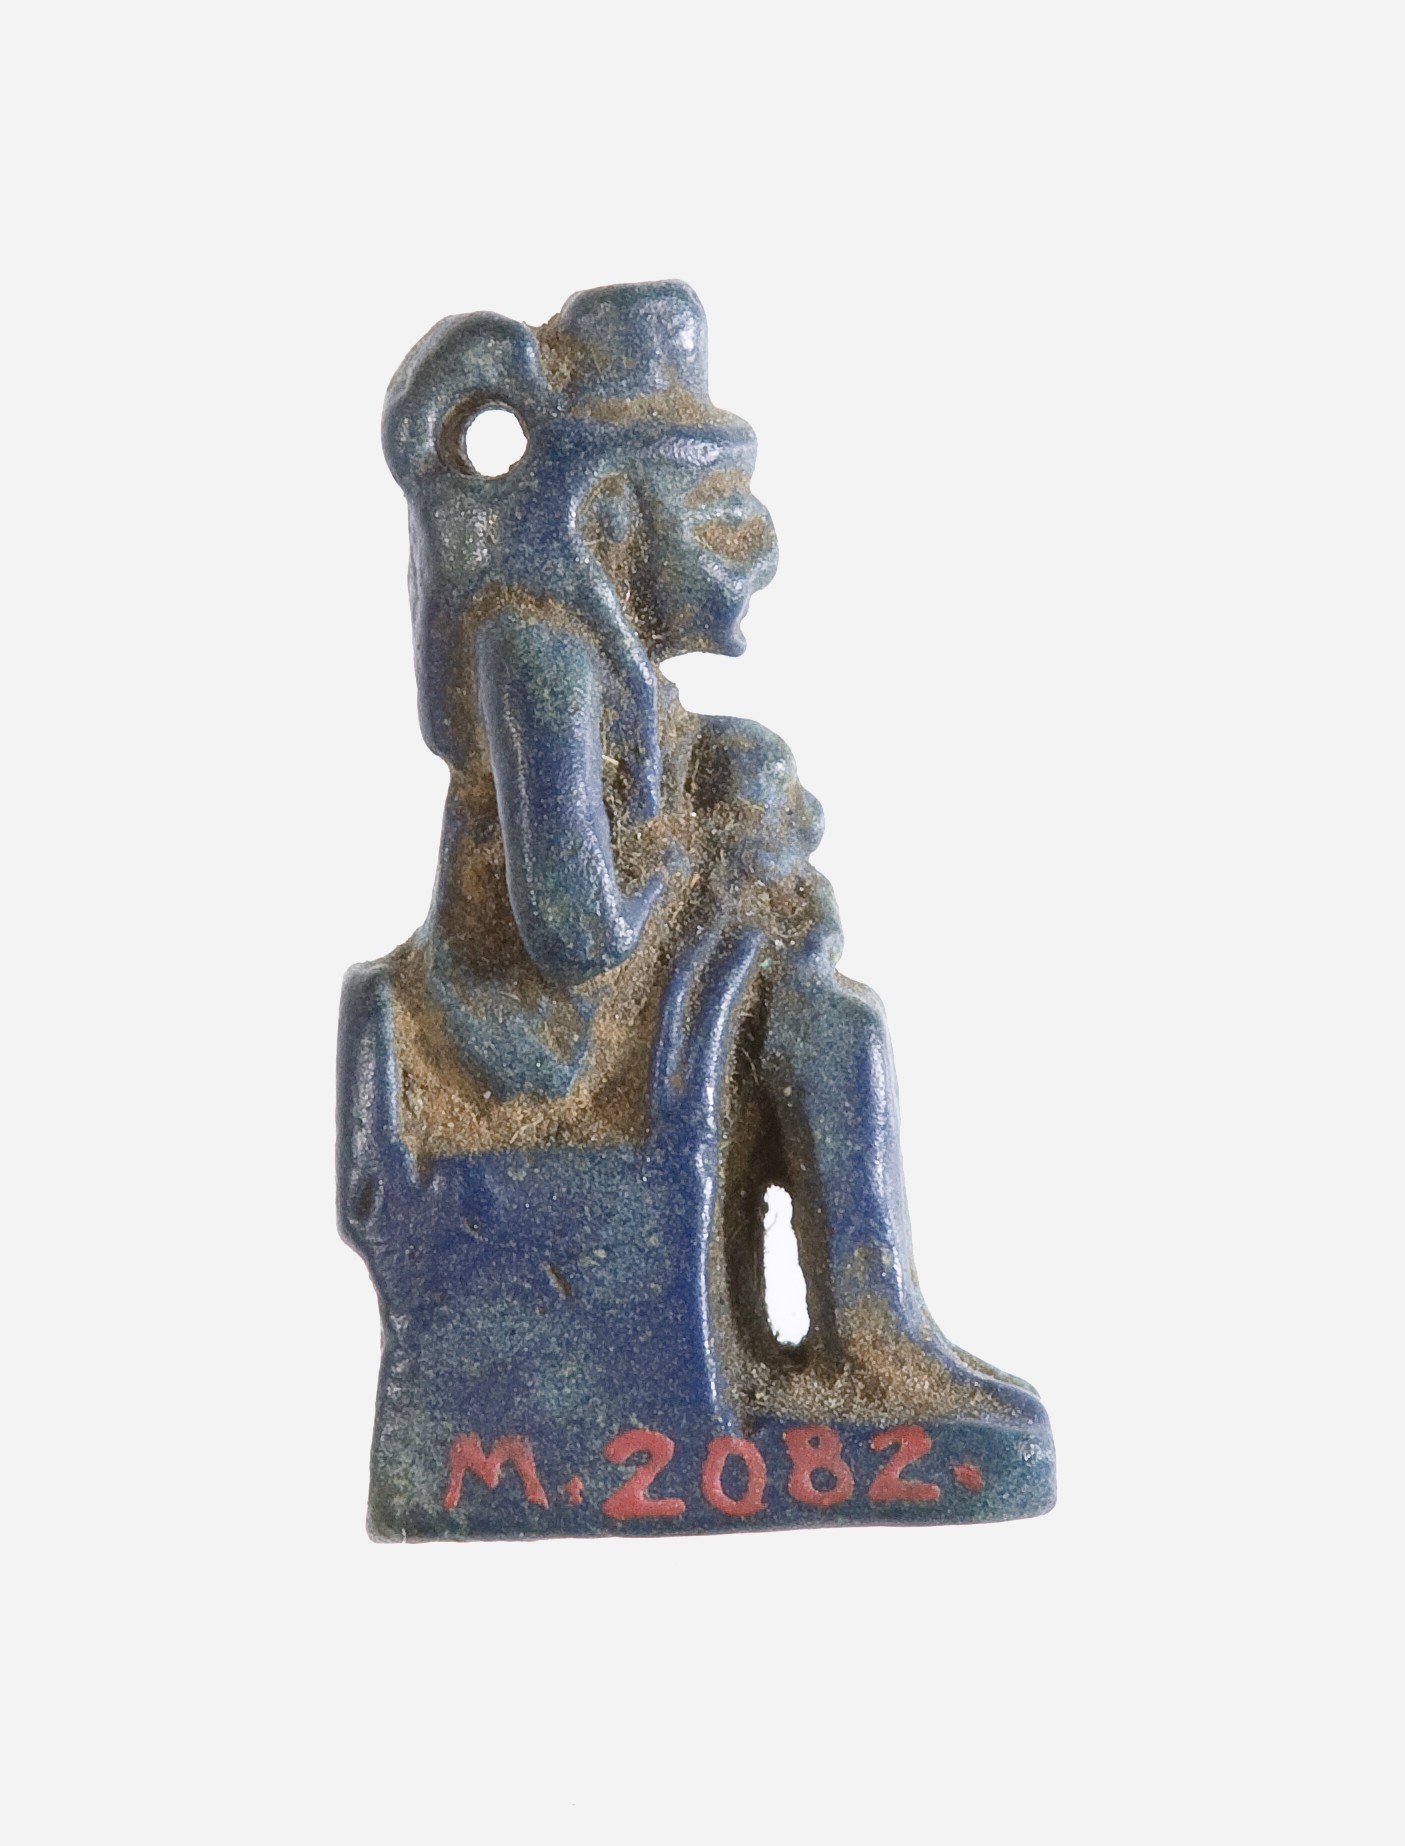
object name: amulet, isi, horus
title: Amulet, Isis, Horus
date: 664-332 BCE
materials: lapis lazuli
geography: egypt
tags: horus,isis